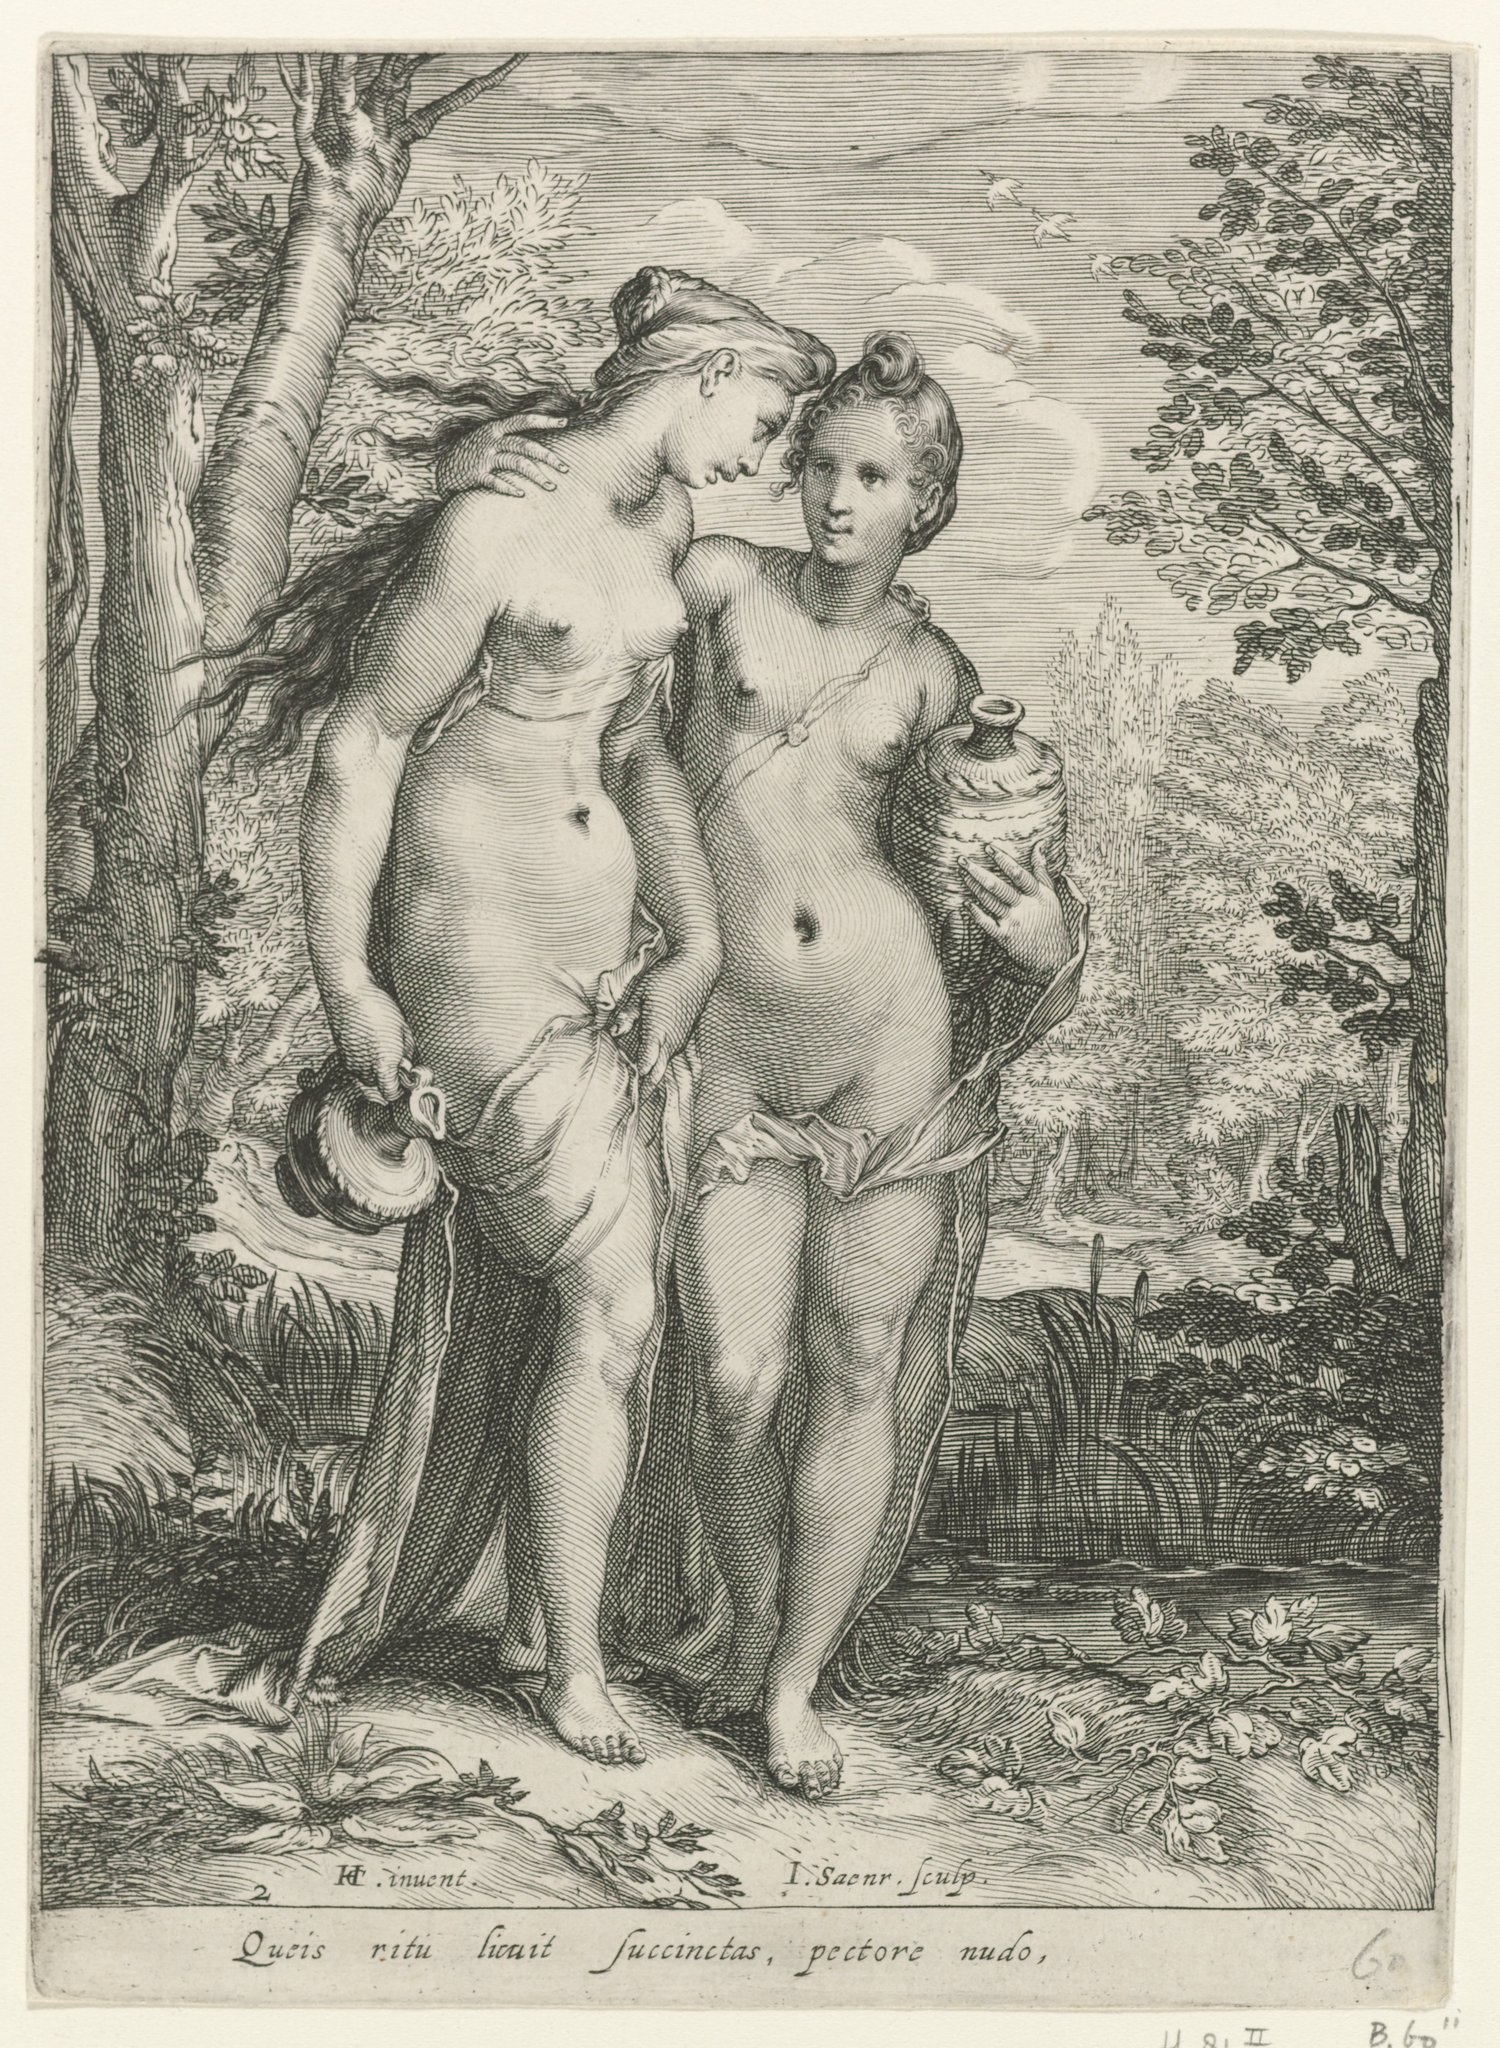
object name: print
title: Diana en haar nimfen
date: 1616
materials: paper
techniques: engraving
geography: assendelft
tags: companions, nymphs of diana; 'ninfe di diana' (ripa), container of ceramics: jar, jug, pot, vase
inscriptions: collector's mark: Lugt 240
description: Twee nimfen uit het gevolg van Diana. Ze houden waterkruiken vast en omarmen elkaar. De prent maakt deel uit van een driedelige serie van Diana en haar nimfen en heeft een Latijns onderschrift.